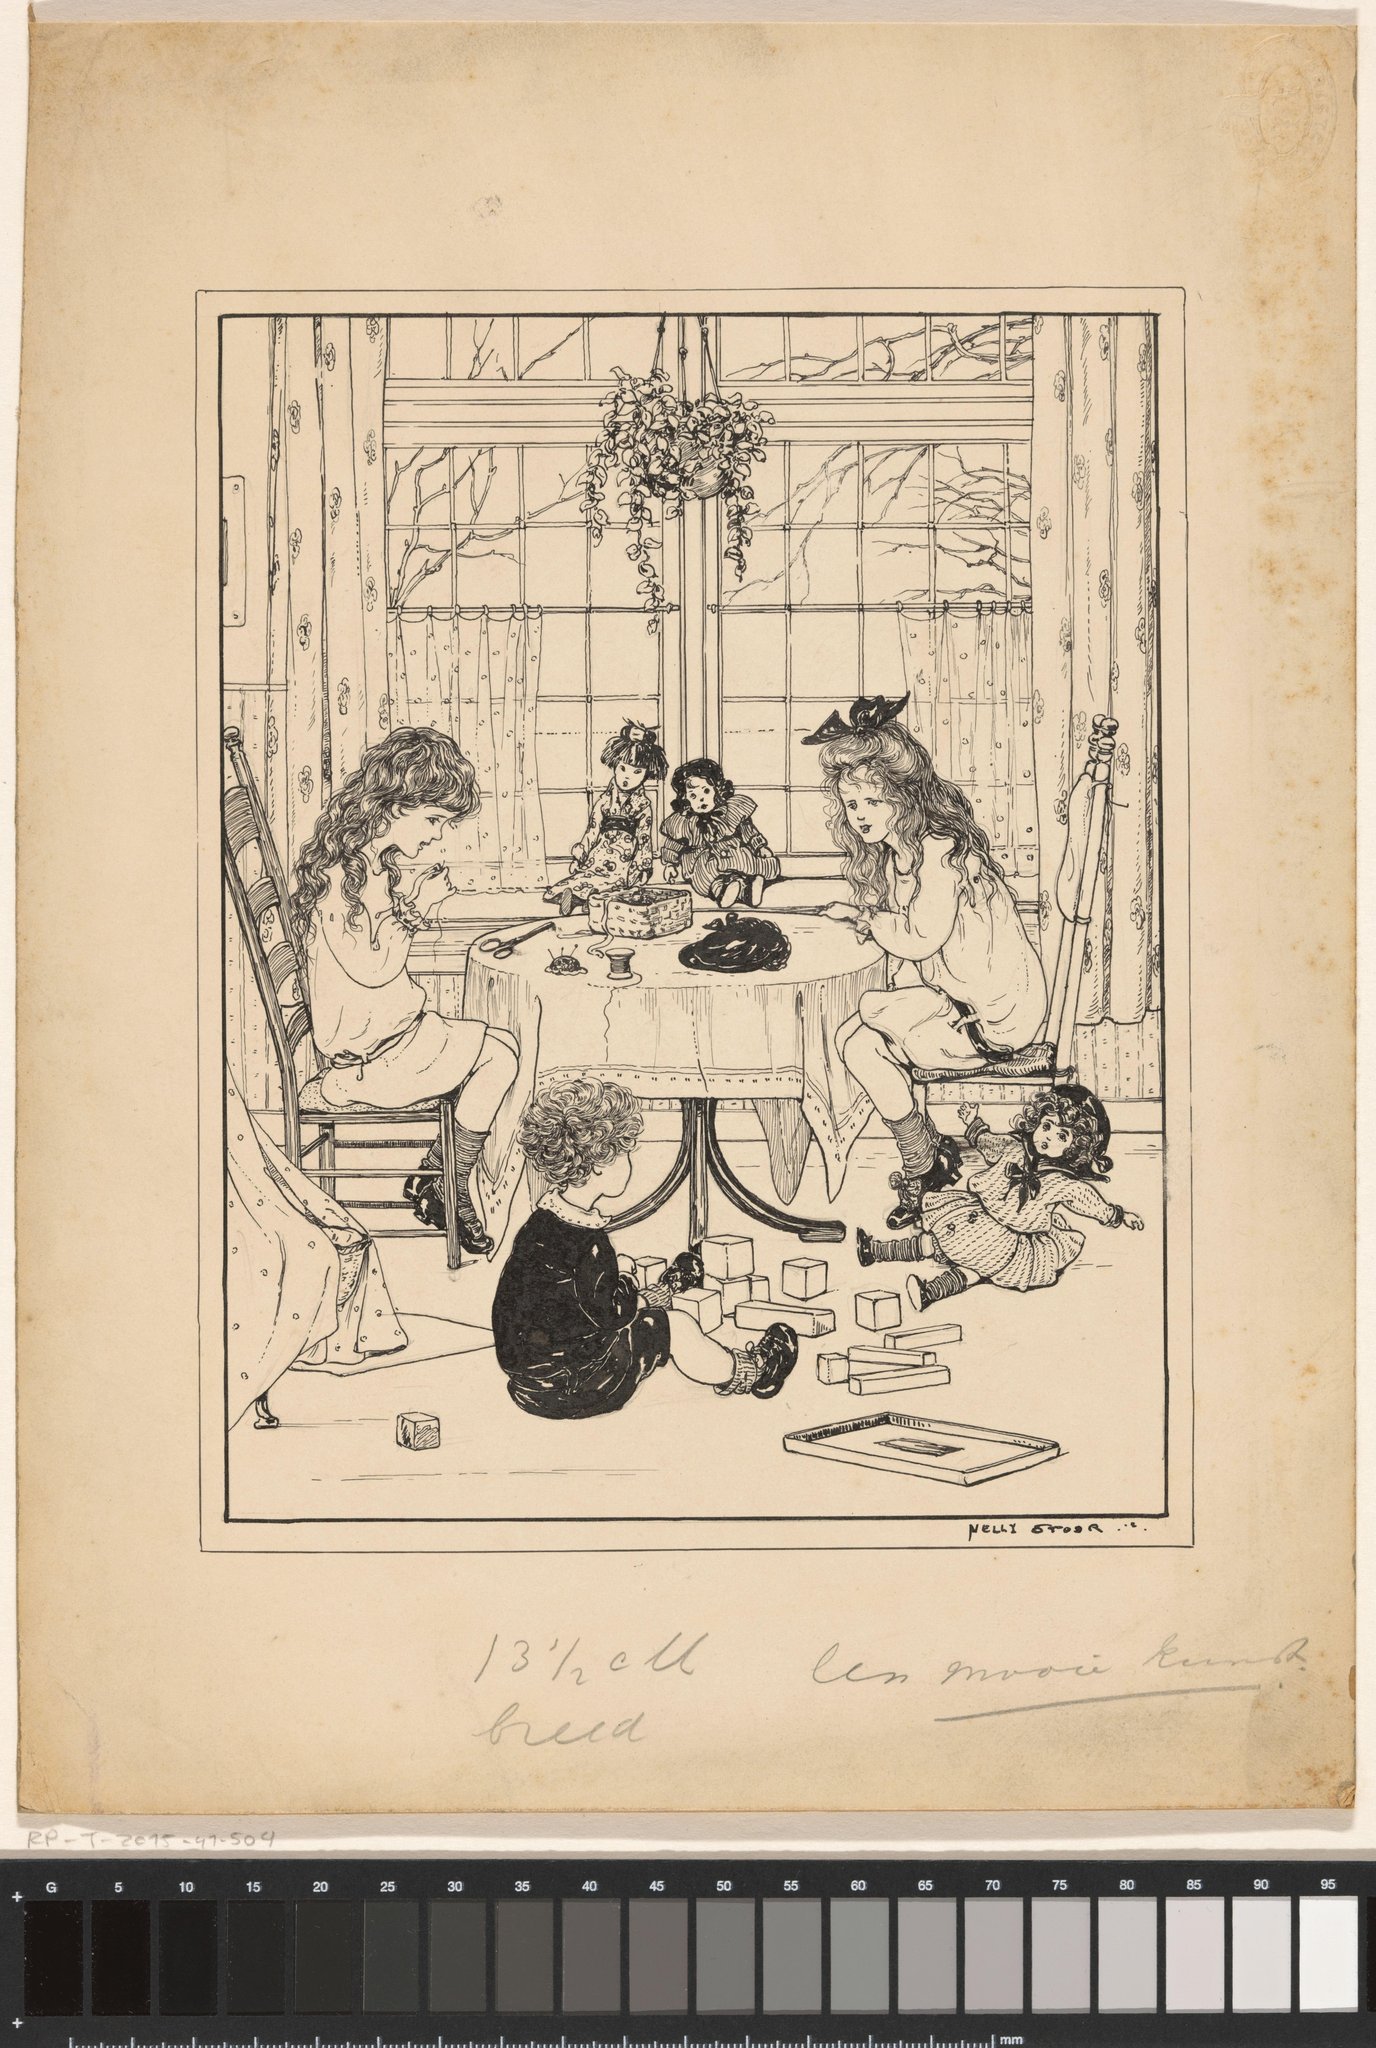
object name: boekillustratie ontwerp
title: Spelende kinderen in een interieur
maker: nelly spoor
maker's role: draughtsman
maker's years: 1885-1950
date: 1918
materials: cardboard, ink, pencil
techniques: brush, pen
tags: (playing with) blocks, interior of the house, (playing with) dolls, needle ~ sewing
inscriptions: check stamp: ‘BRISTOL/ A L’, annotation: ‘een mooie kunst’, collector's mark: Lugt 2228, signature and date: ‘NELLY SPOOR . 18 .’, :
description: Twee meisjes zitten aan een tafel bij een venster. Eén meisje probeert een draad door het oog van een naald te rijgen. Op tafel ligt naaigerei en op de grond en in de vensterbank staan poppen. Op de grond speelt een jongen met blokken.